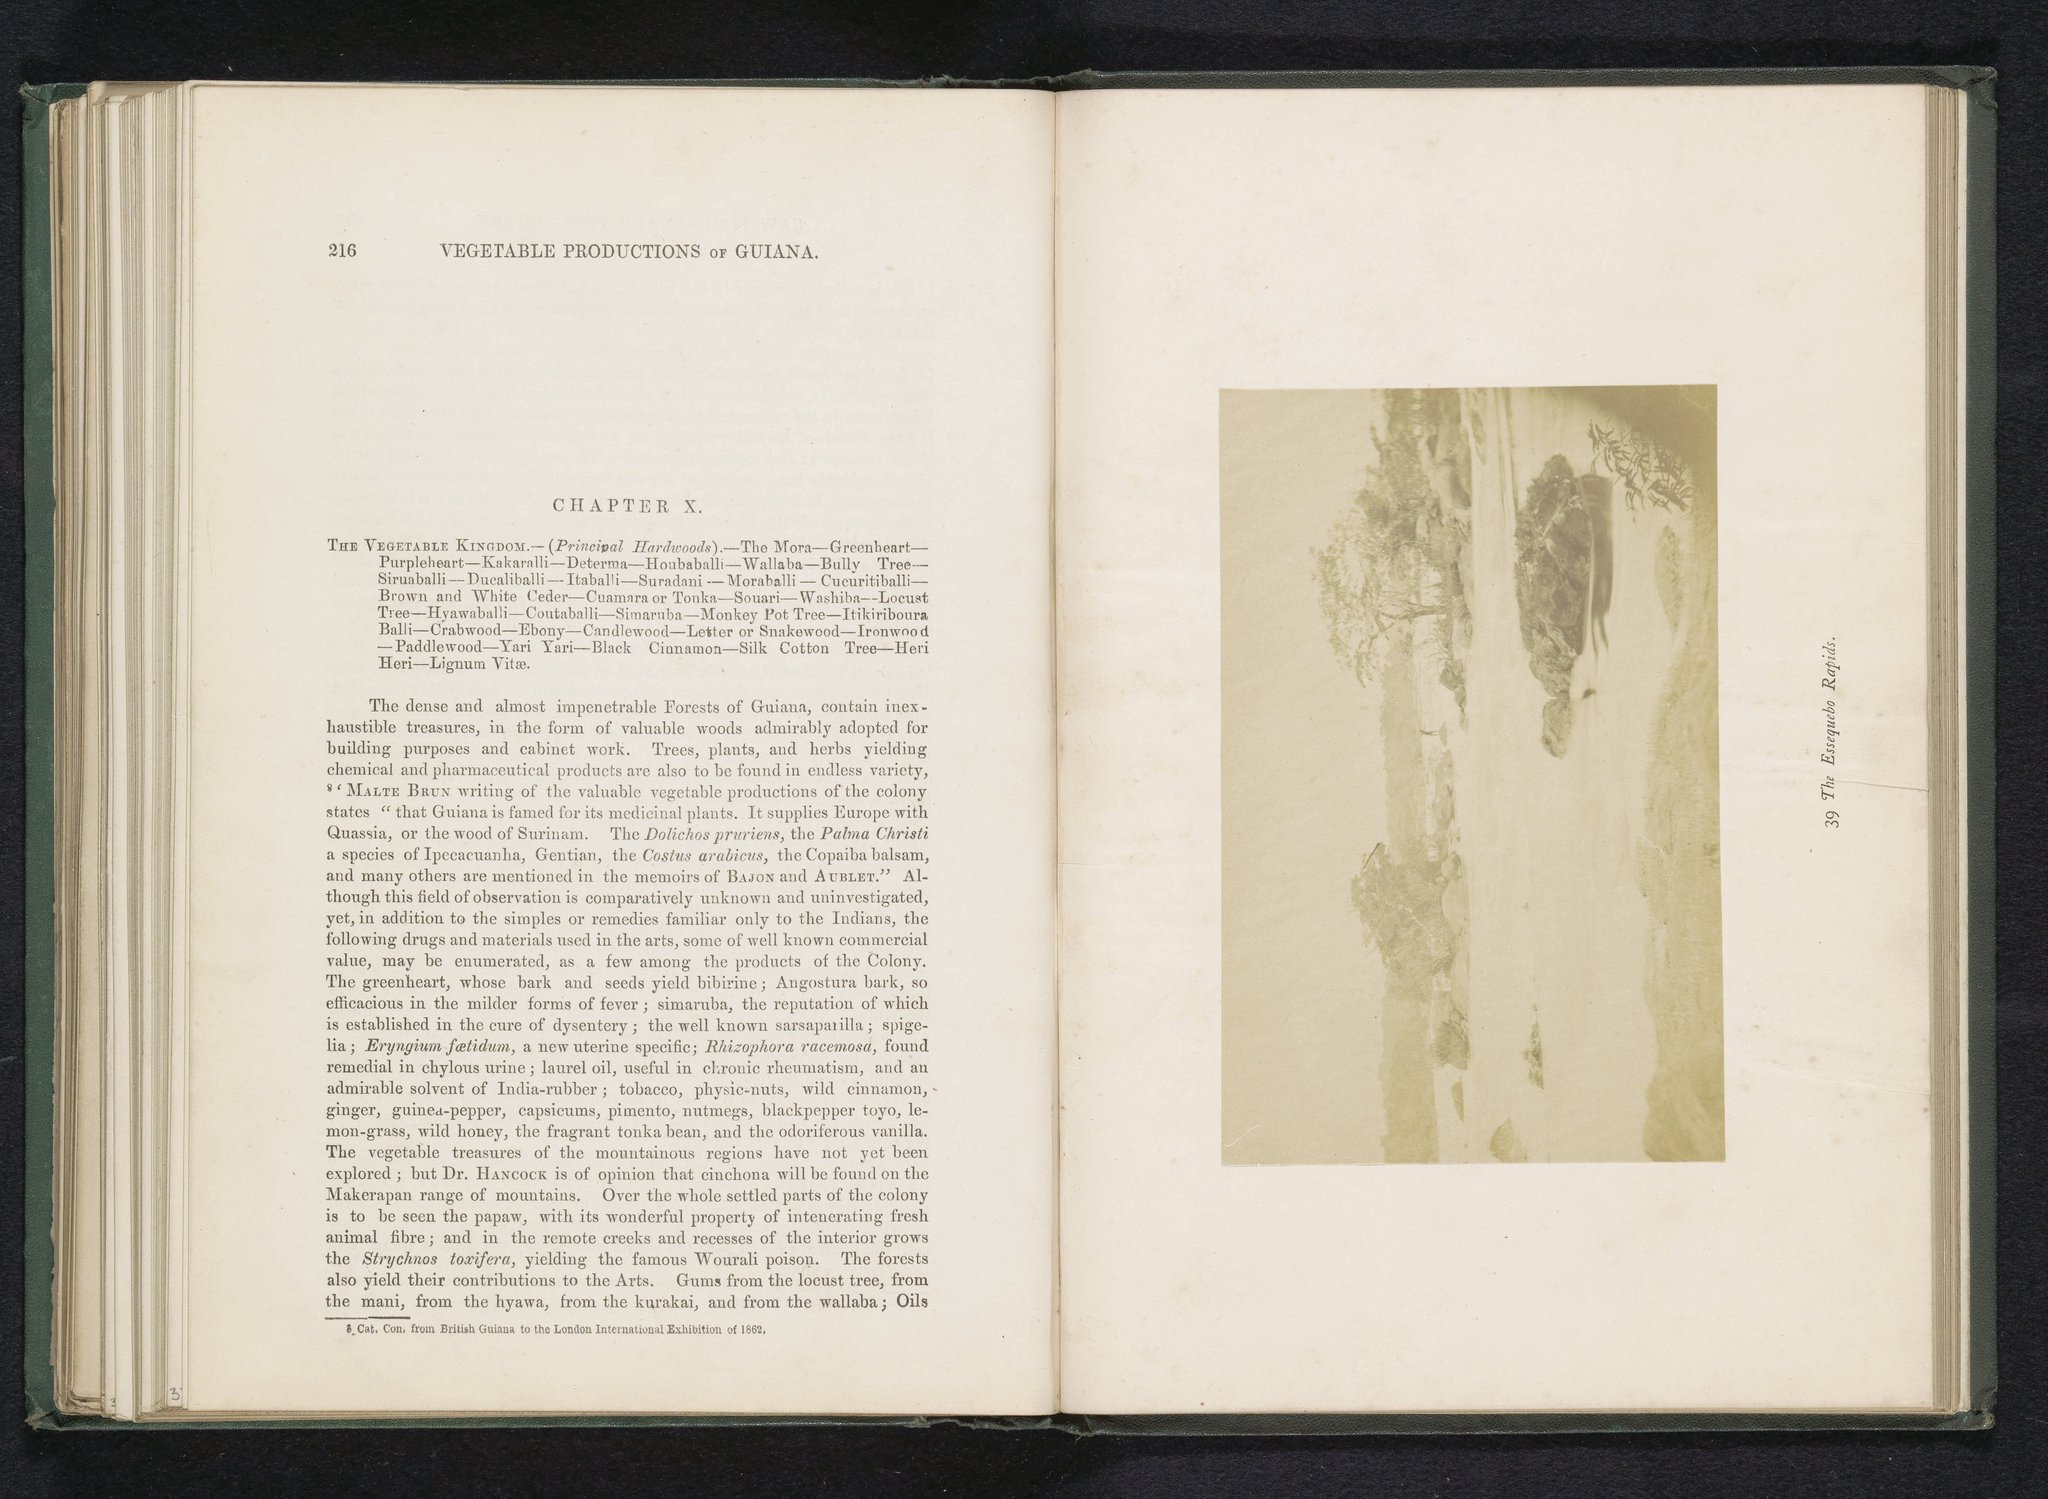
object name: page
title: Stroomversnellingen in de Essequibo in Guyana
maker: Anonymous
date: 1856-1866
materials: photographic support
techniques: albumen print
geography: guyana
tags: rapids, river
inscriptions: number: ‘39’